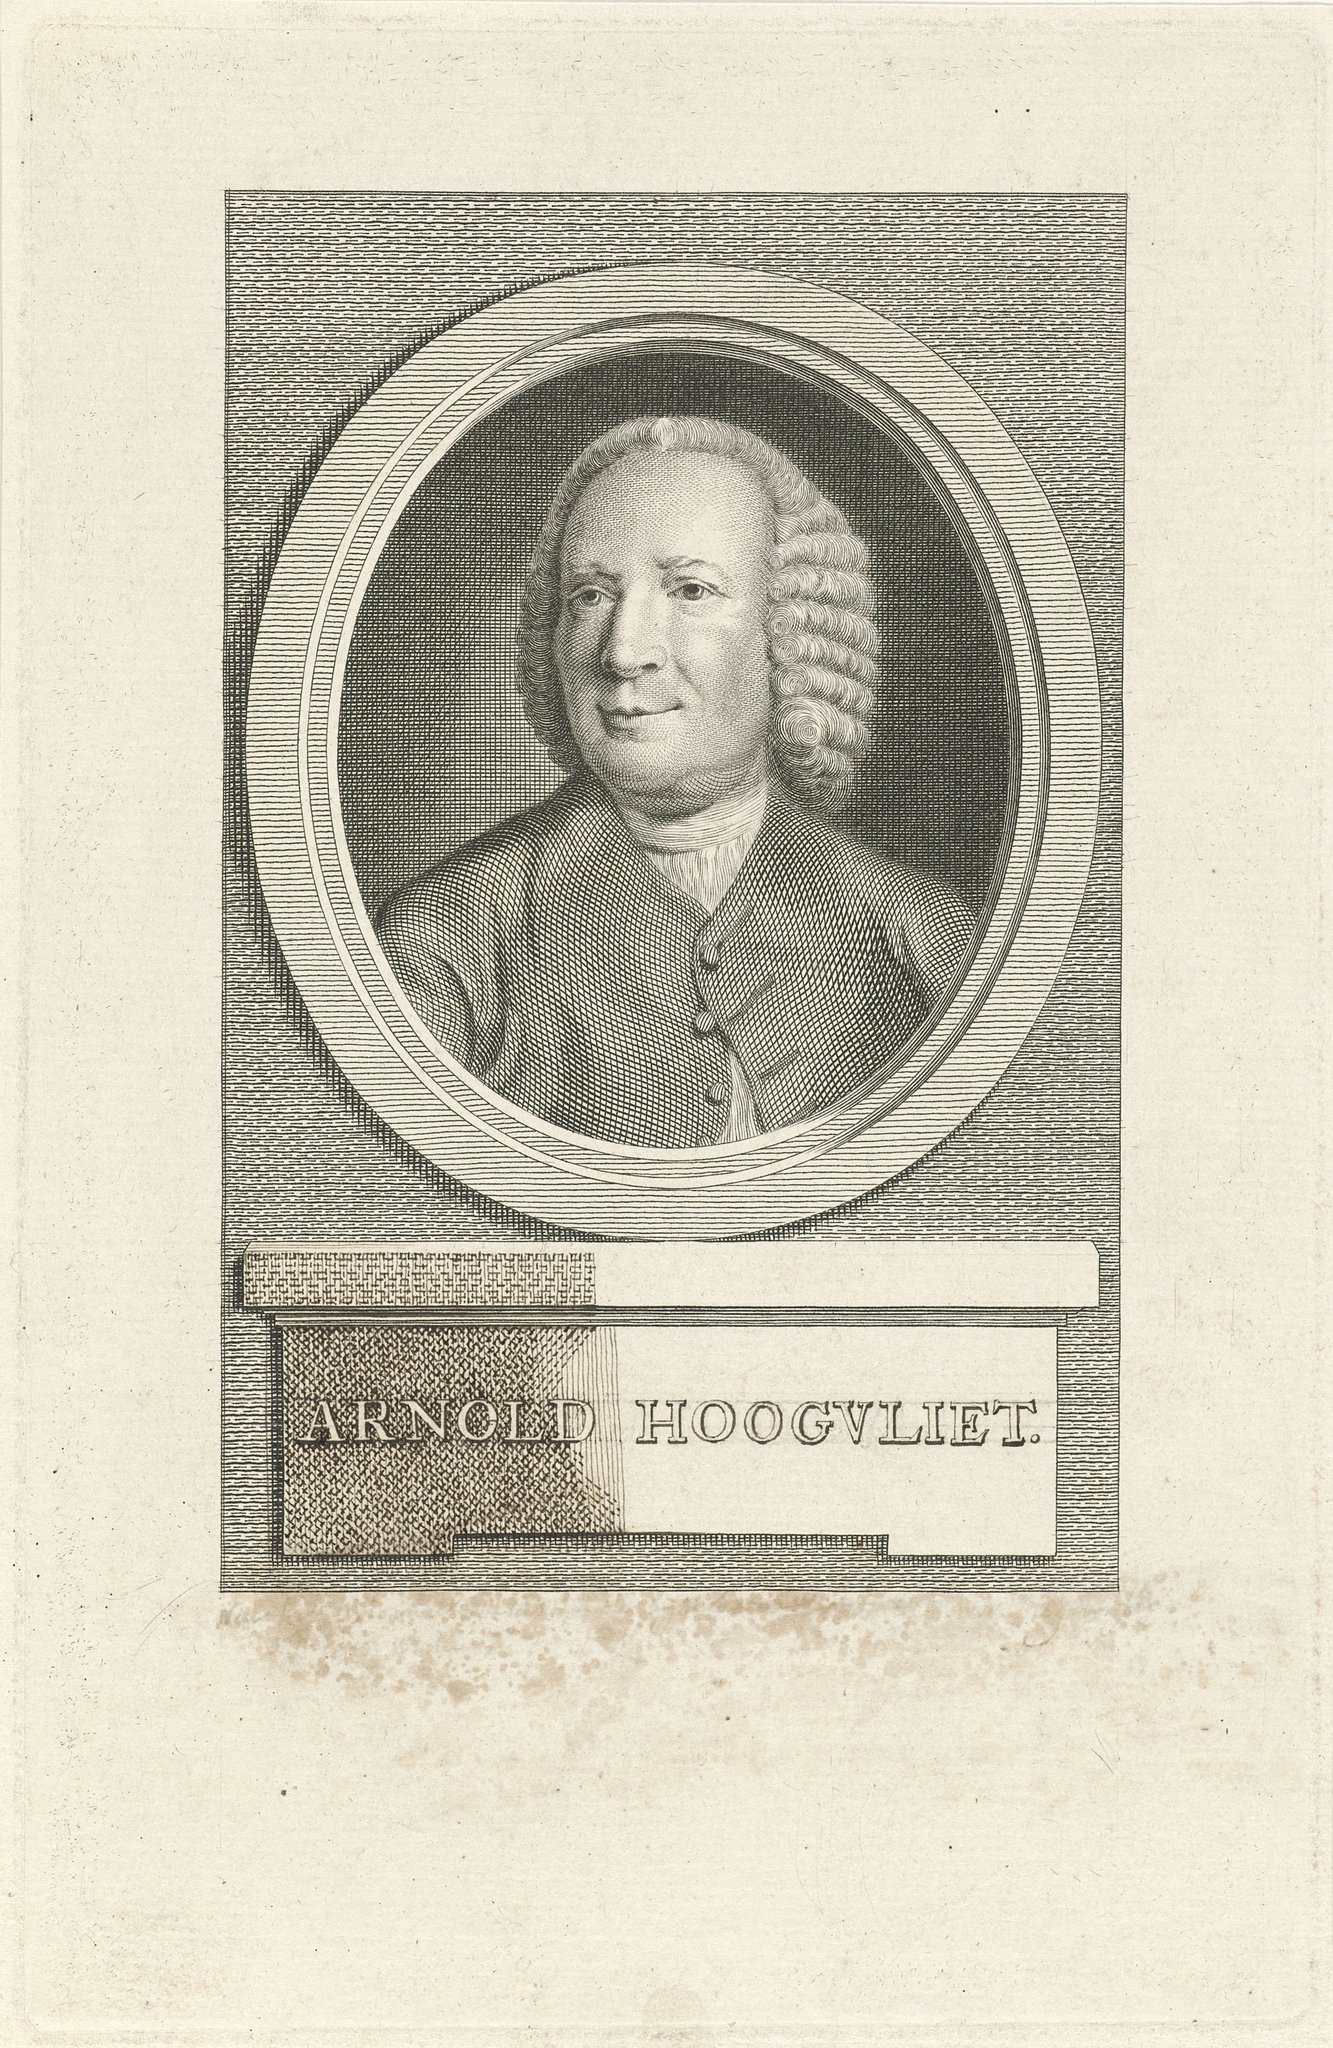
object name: print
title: Portret van Arnold Hoogvliet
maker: pieter willem van megen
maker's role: print maker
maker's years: 1750-1785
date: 1760-1785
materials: ink, paper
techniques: engraving, etching, pen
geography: the hague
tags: arnold hoogvliet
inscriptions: collector's mark: Lugt 240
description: Portret van de dichter Arnold Hoogvliet in een ovale lijst.